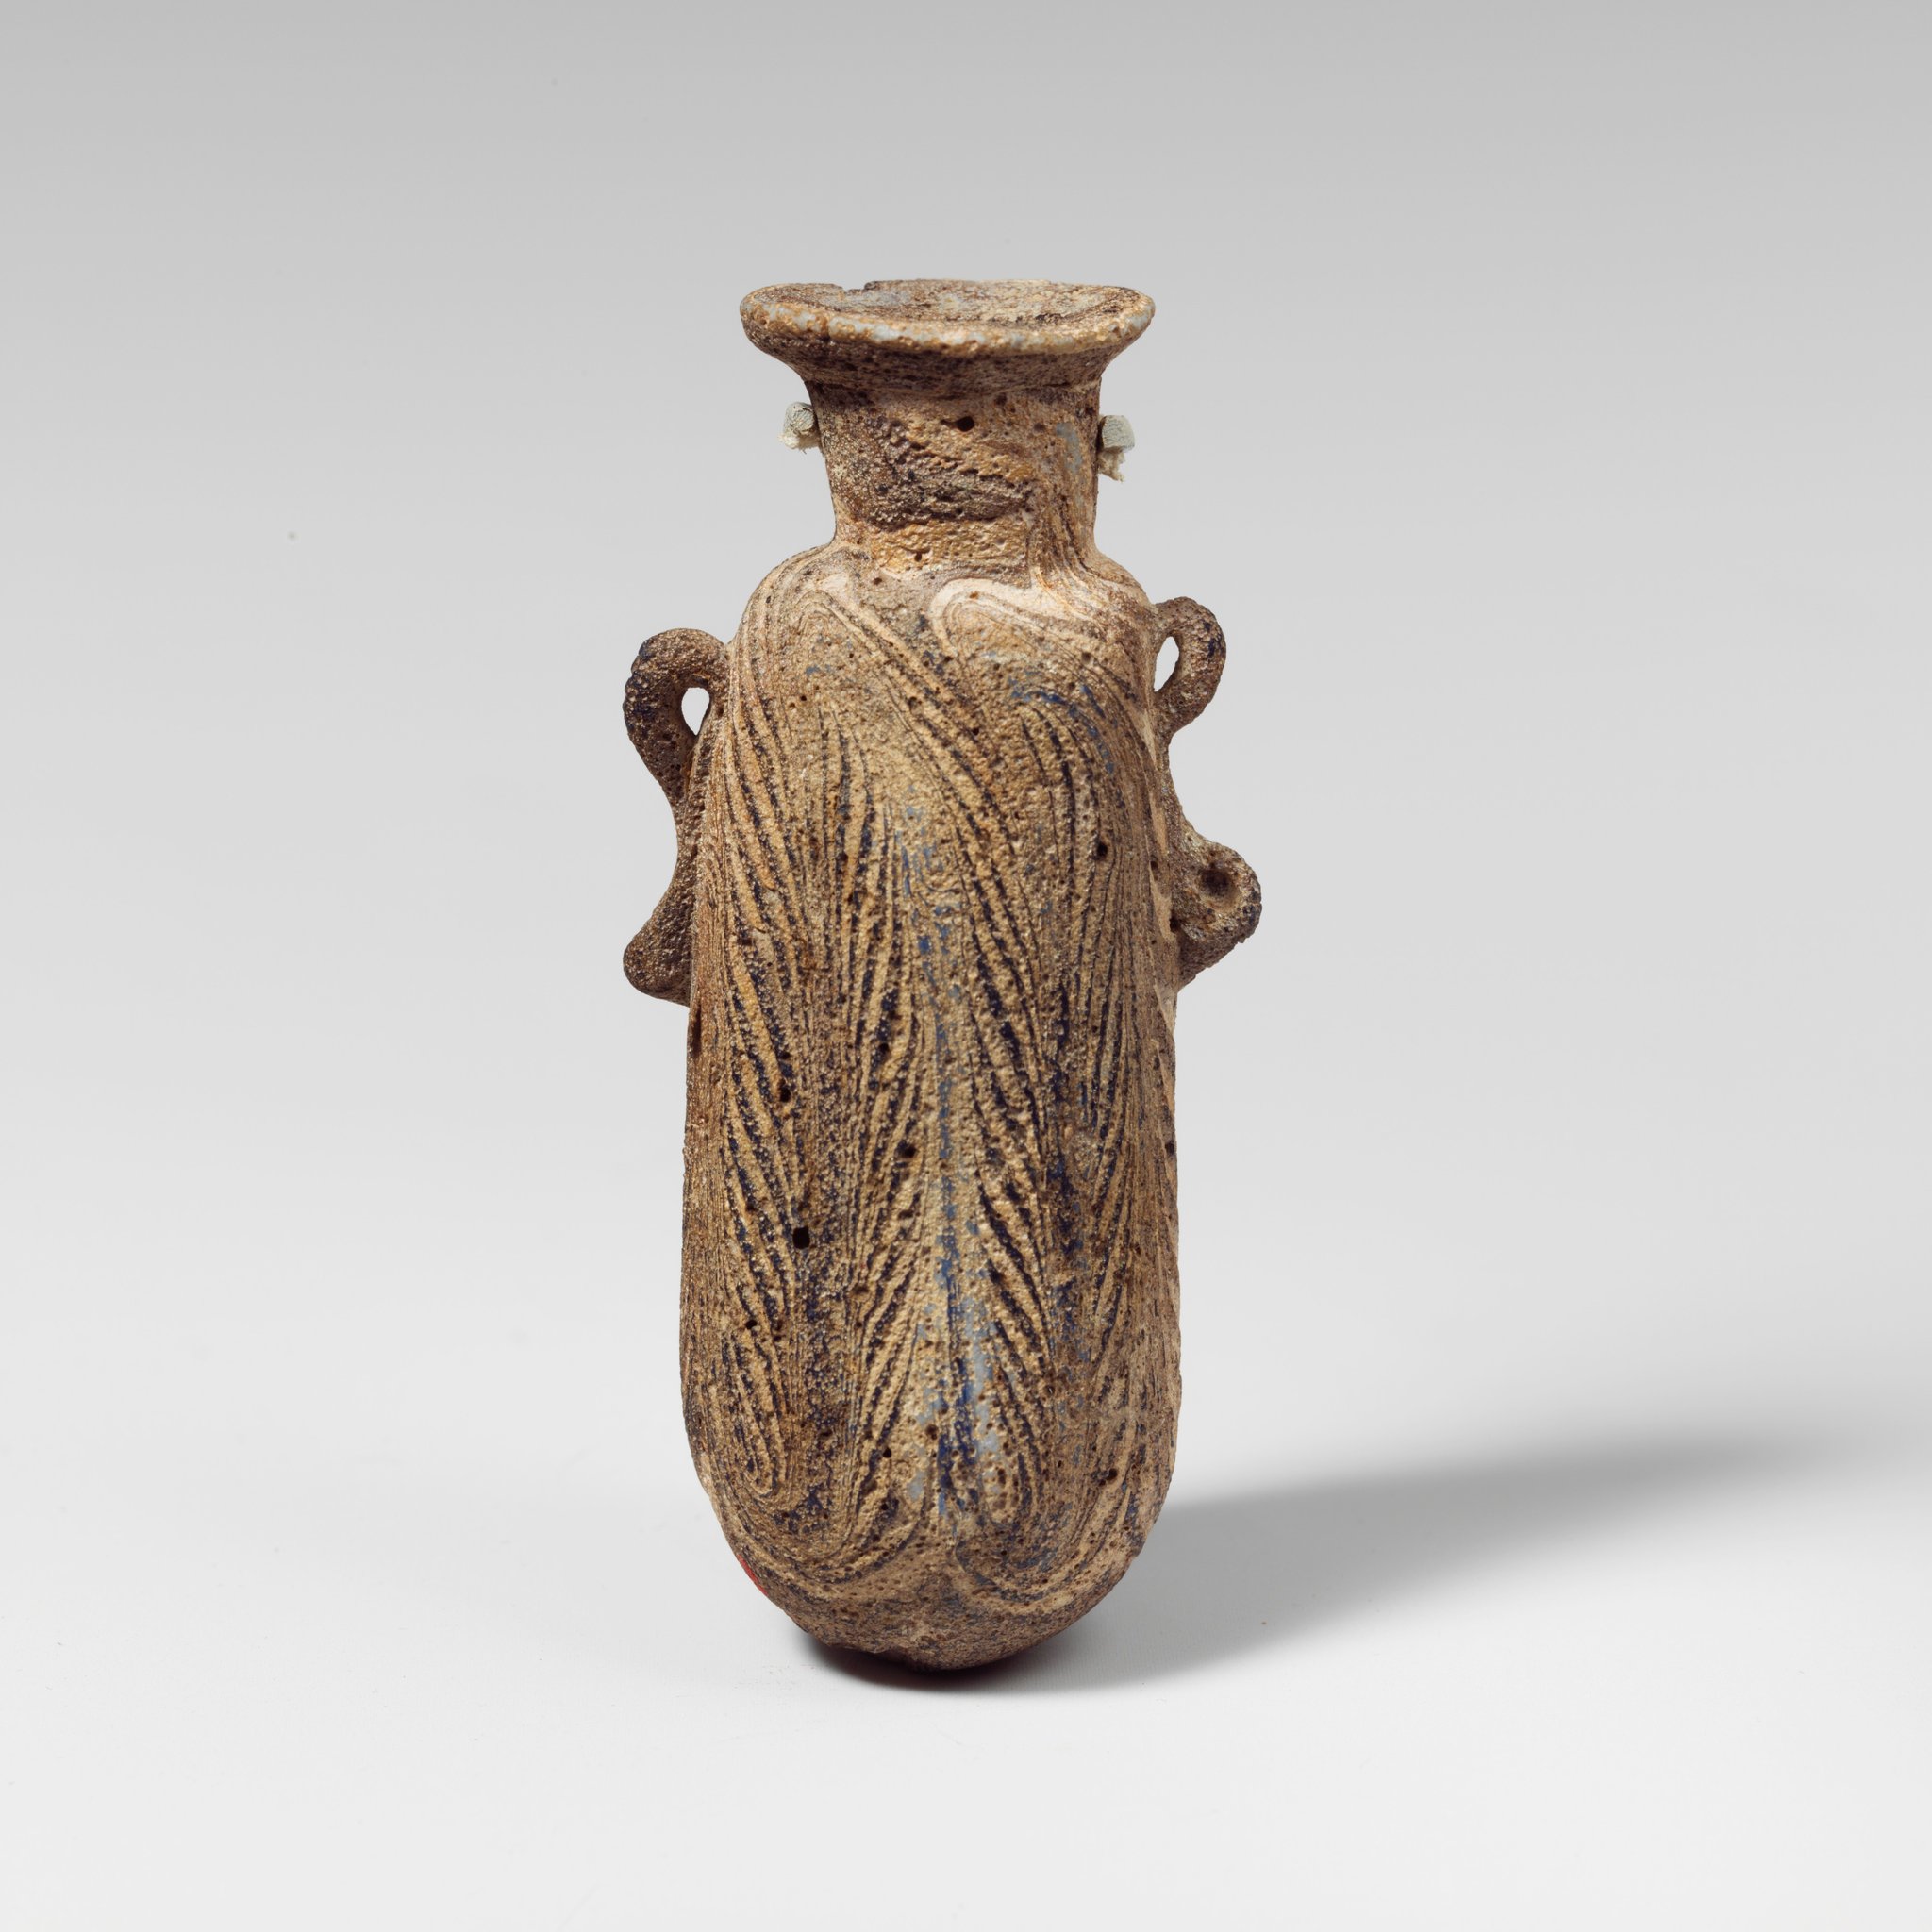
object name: alabastron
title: Glass alabastron (perfume bottle)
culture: greek, eastern mediterranean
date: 534-401 BCE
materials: glass